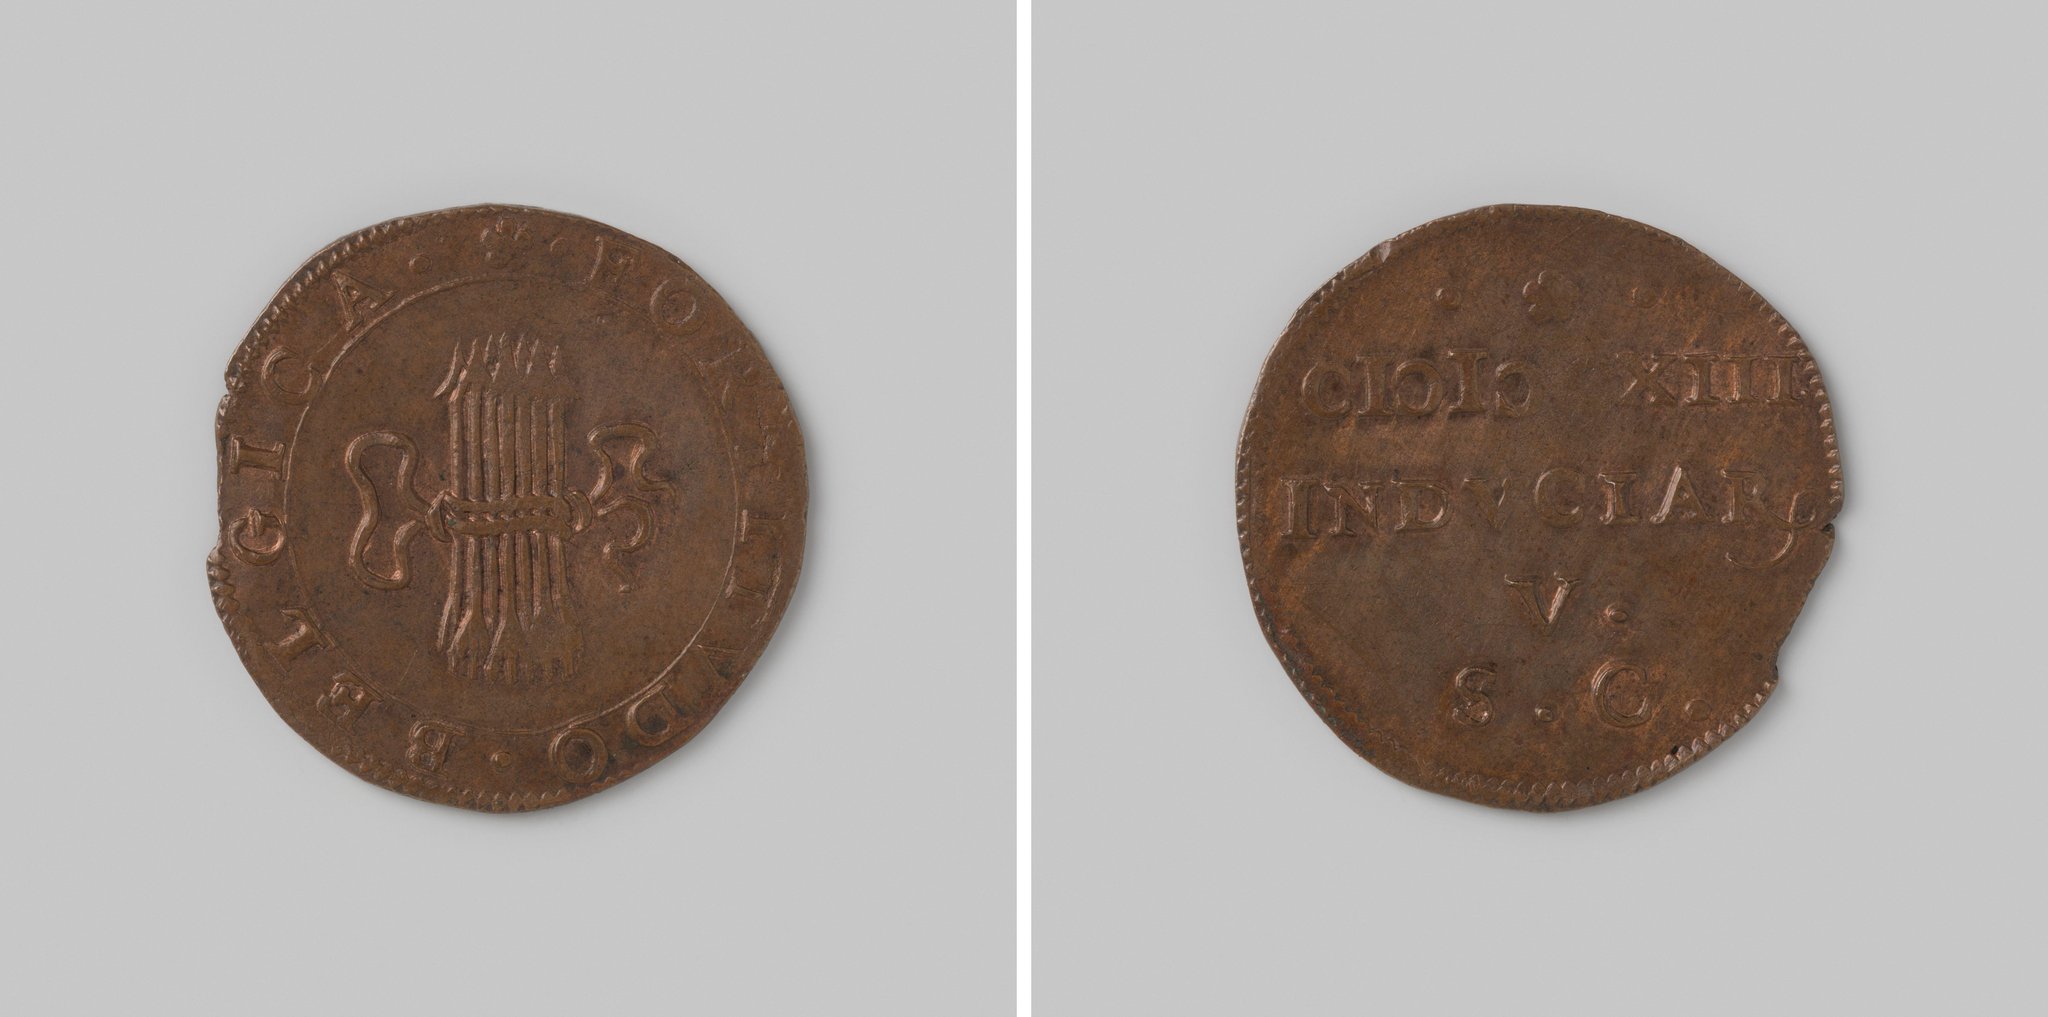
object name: history medal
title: Rekenpenning uit Utrecht op het herstel van de rust in Utrecht 1613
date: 1613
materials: copper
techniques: striking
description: Koperen penning, op de voorzijde een pijlenbundel met omschrift, op de keerzijde vier regels tekst.